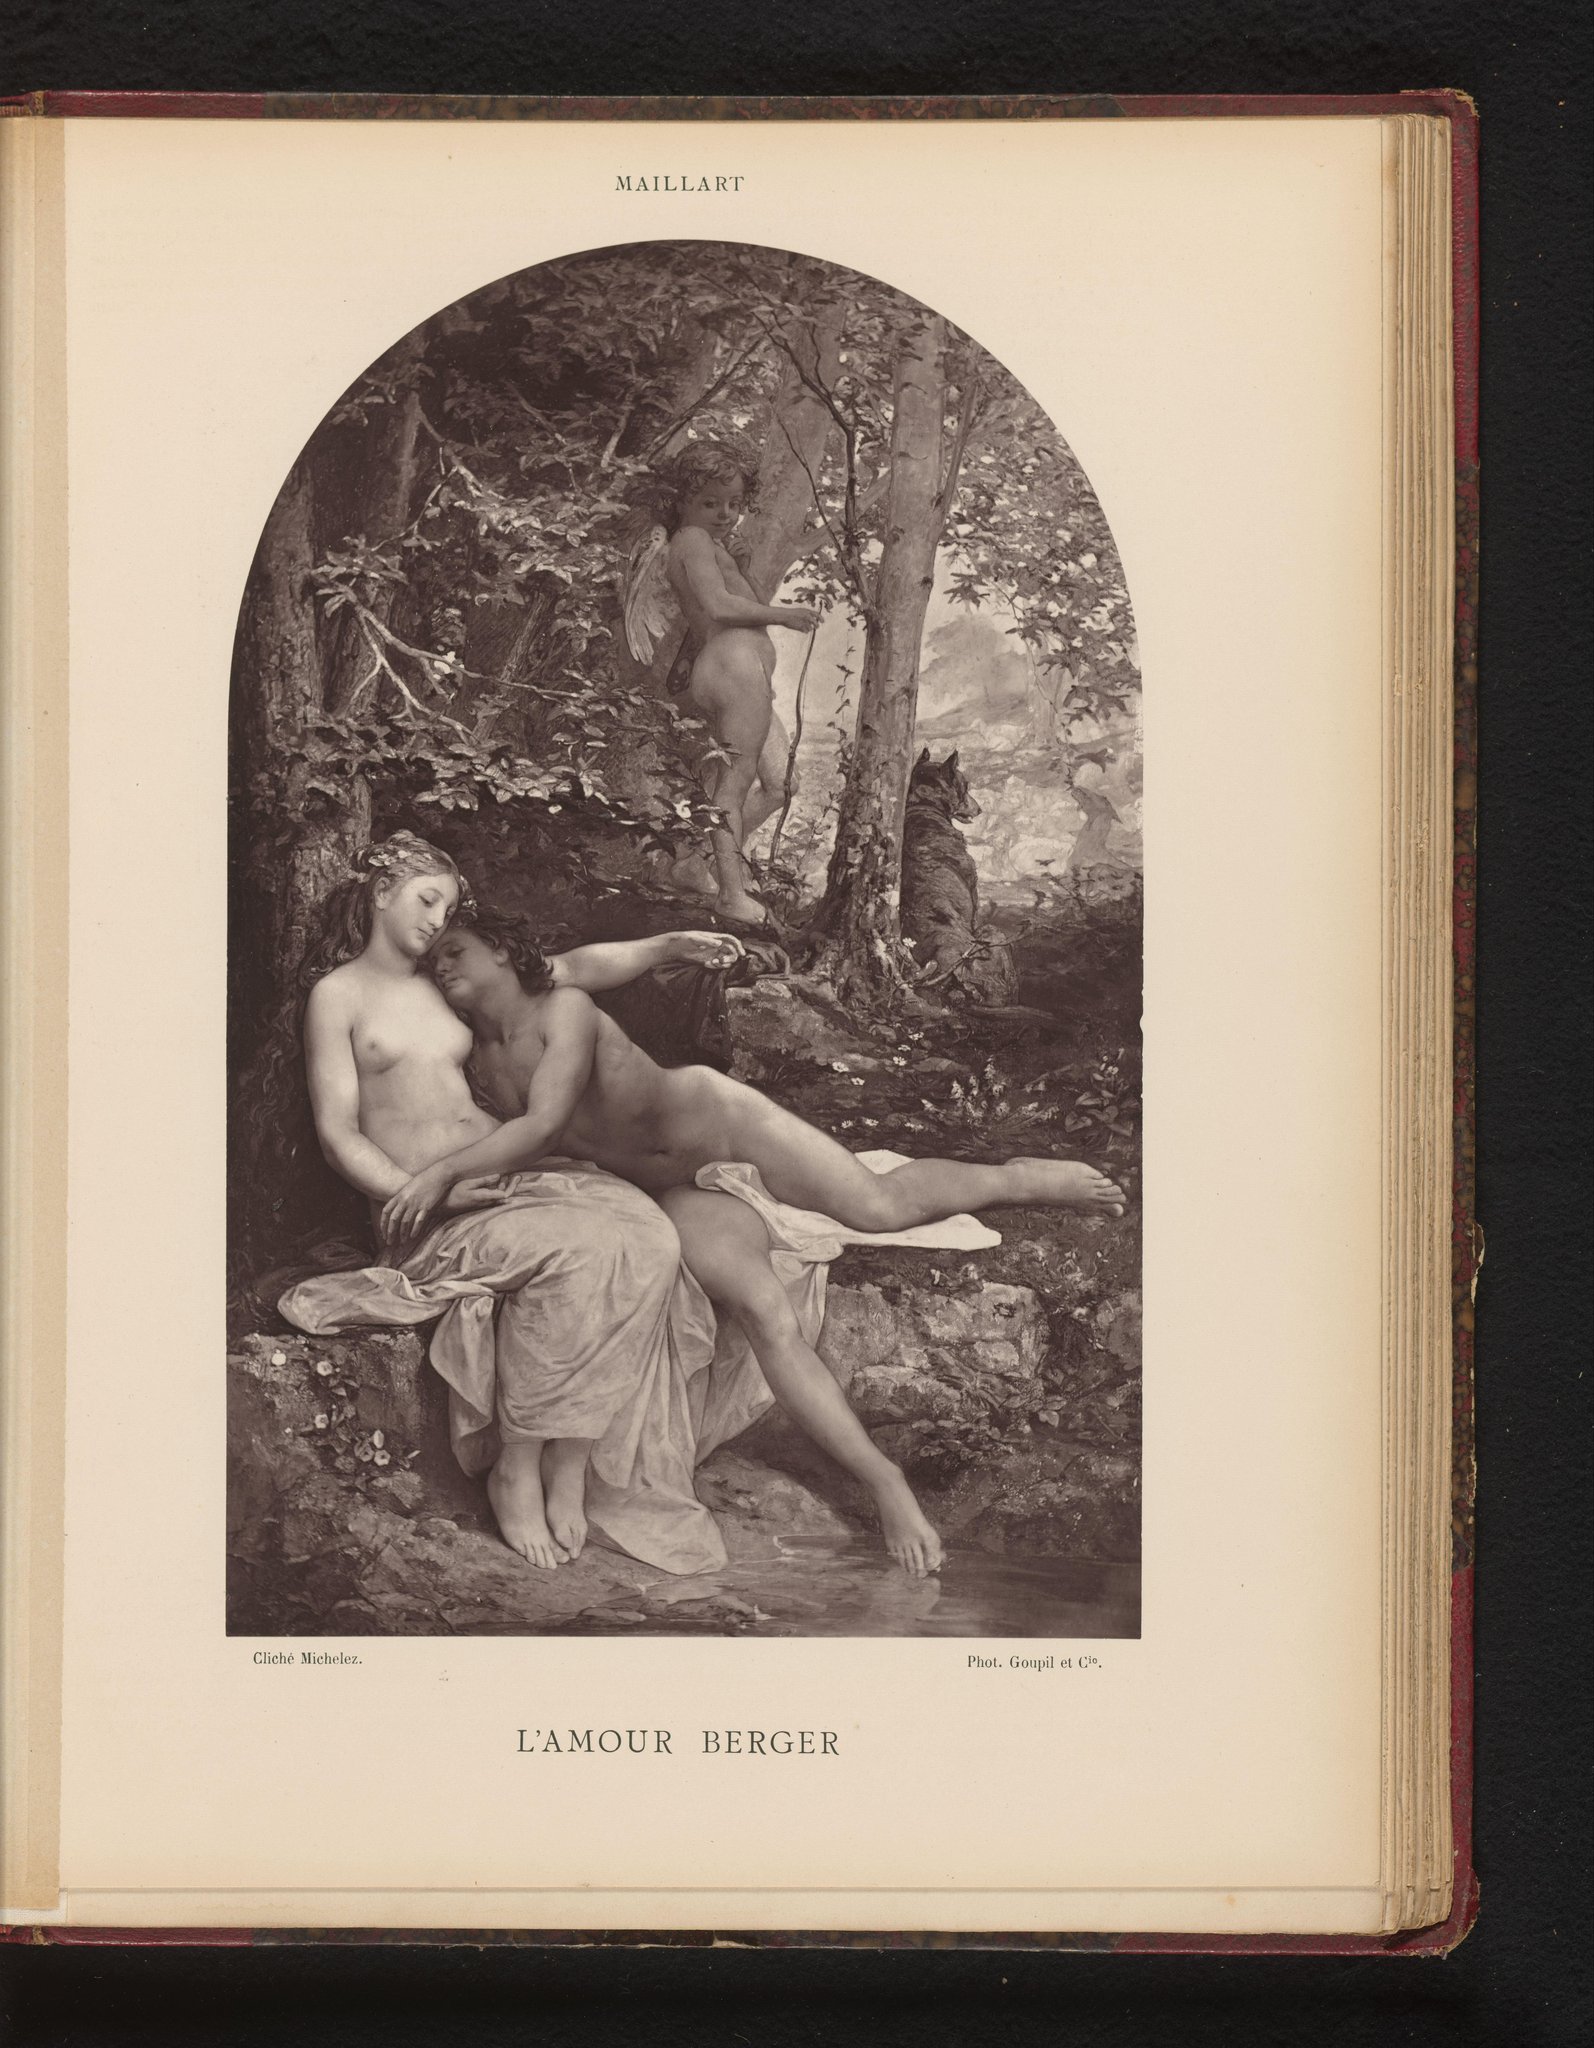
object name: photomechanical print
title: l'Amour berger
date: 1876-1881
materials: paper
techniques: woodburytype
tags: couple of lovers